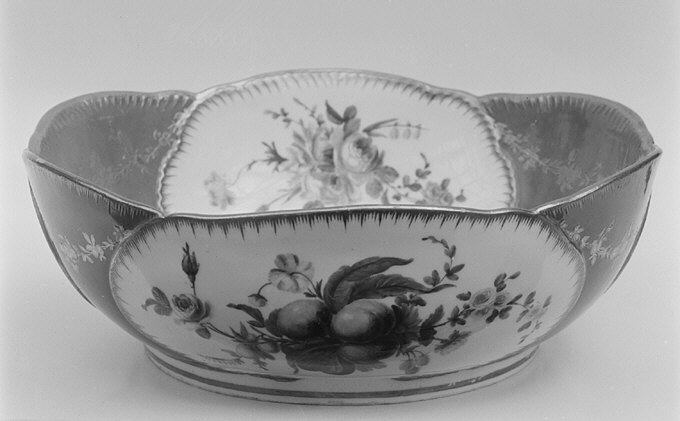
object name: salad bowl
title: Salad bowl (saladier) (one of six) (part of a service)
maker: sèvres manufactory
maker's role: manufactory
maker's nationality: french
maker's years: 1740-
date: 1771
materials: soft paste porcelain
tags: fruit,flowers